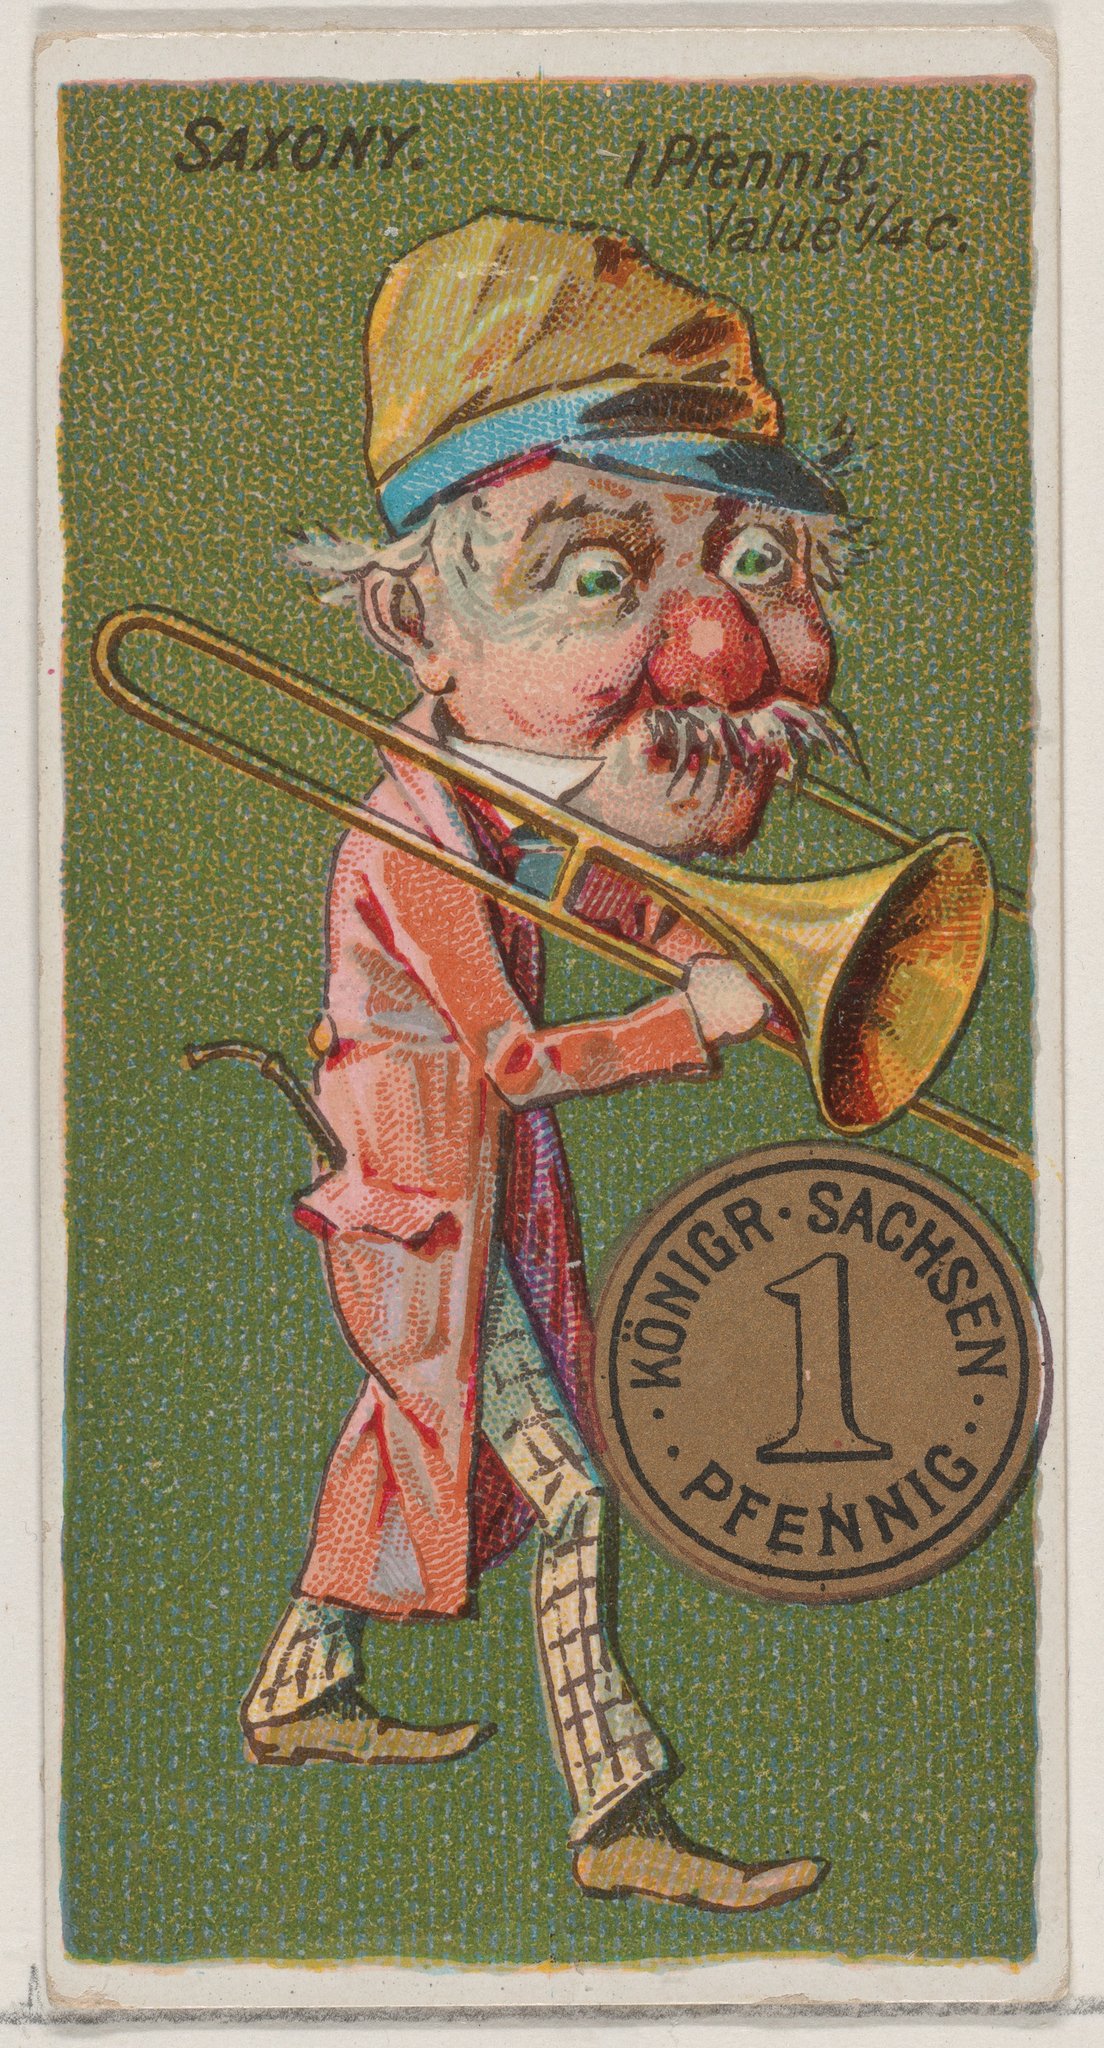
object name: print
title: Saxony, 1 Pfennig, from the series Coins of All Nations (N72, variation 2) for Duke brand cigarettes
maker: w. duke, sons & co.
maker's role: publisher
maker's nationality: american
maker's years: 1870-1920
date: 1889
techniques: color lithograph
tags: musical instruments,men,coins